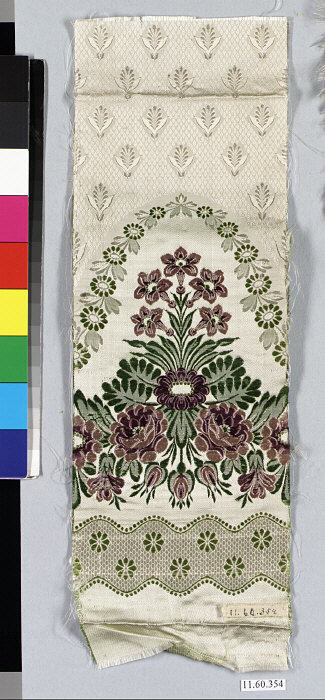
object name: fragment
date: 1801-1900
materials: silk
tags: flowers,leaves